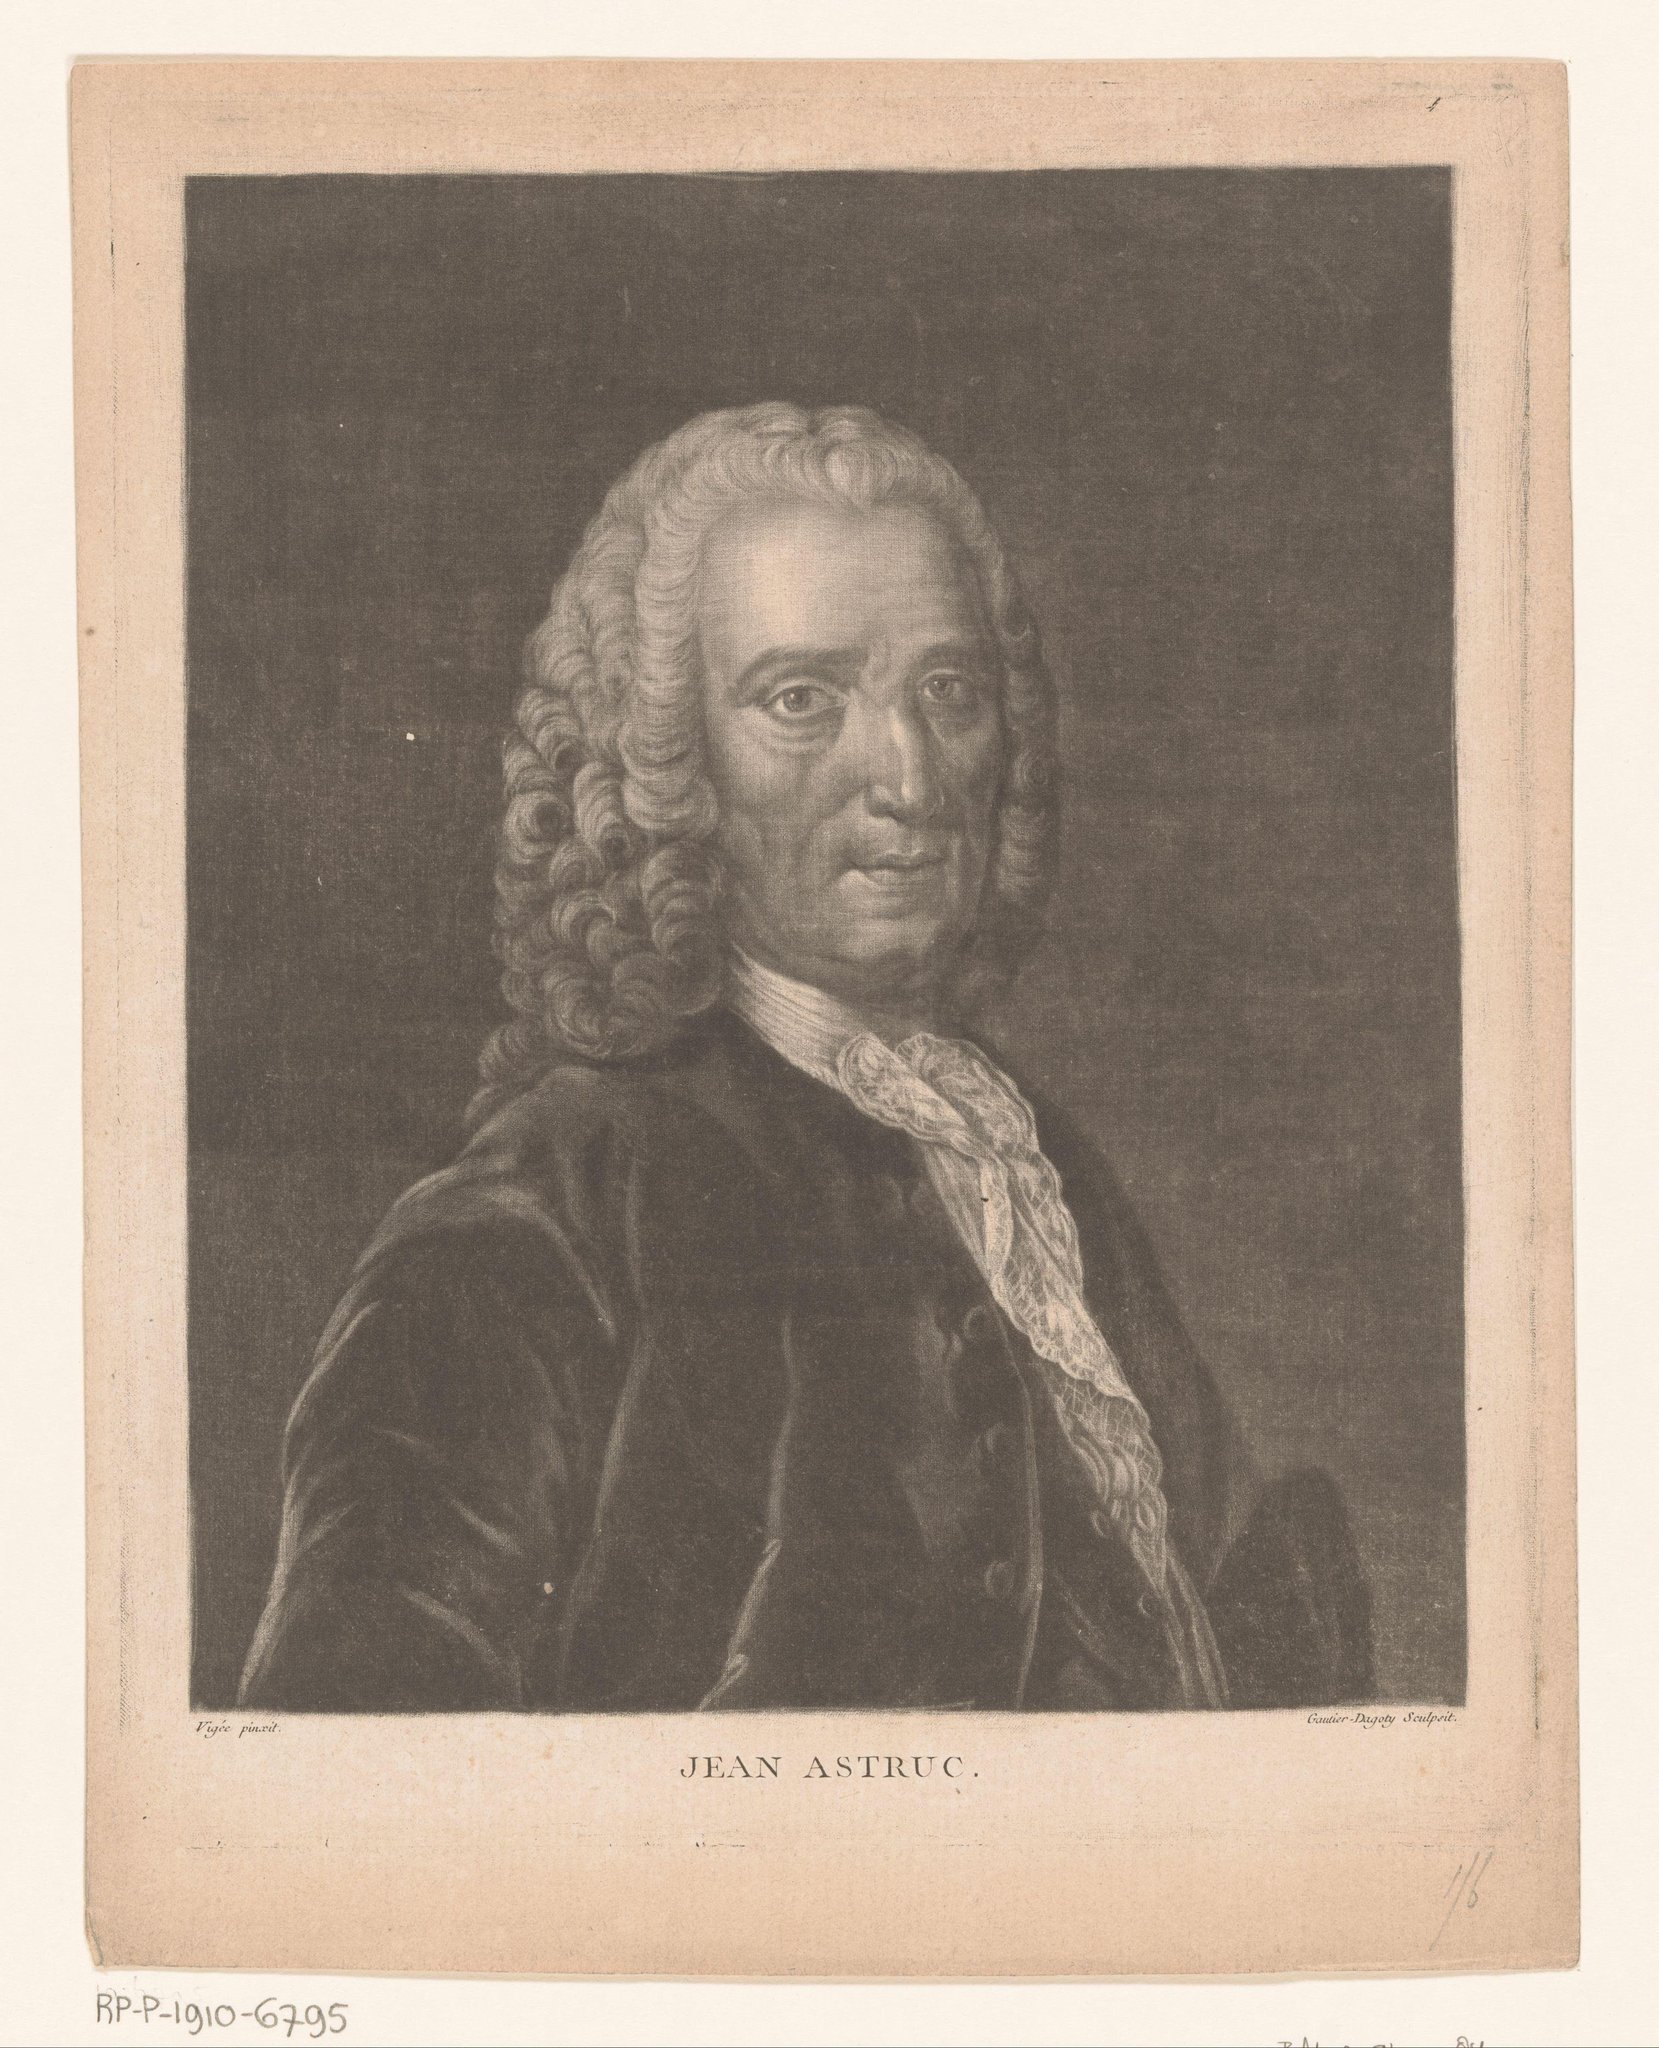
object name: print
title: Portret van Jean Astruc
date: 1750-1786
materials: paper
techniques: mezzotint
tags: paris, historical persons, physician, doctor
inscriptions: collector's mark: Lugt 2228